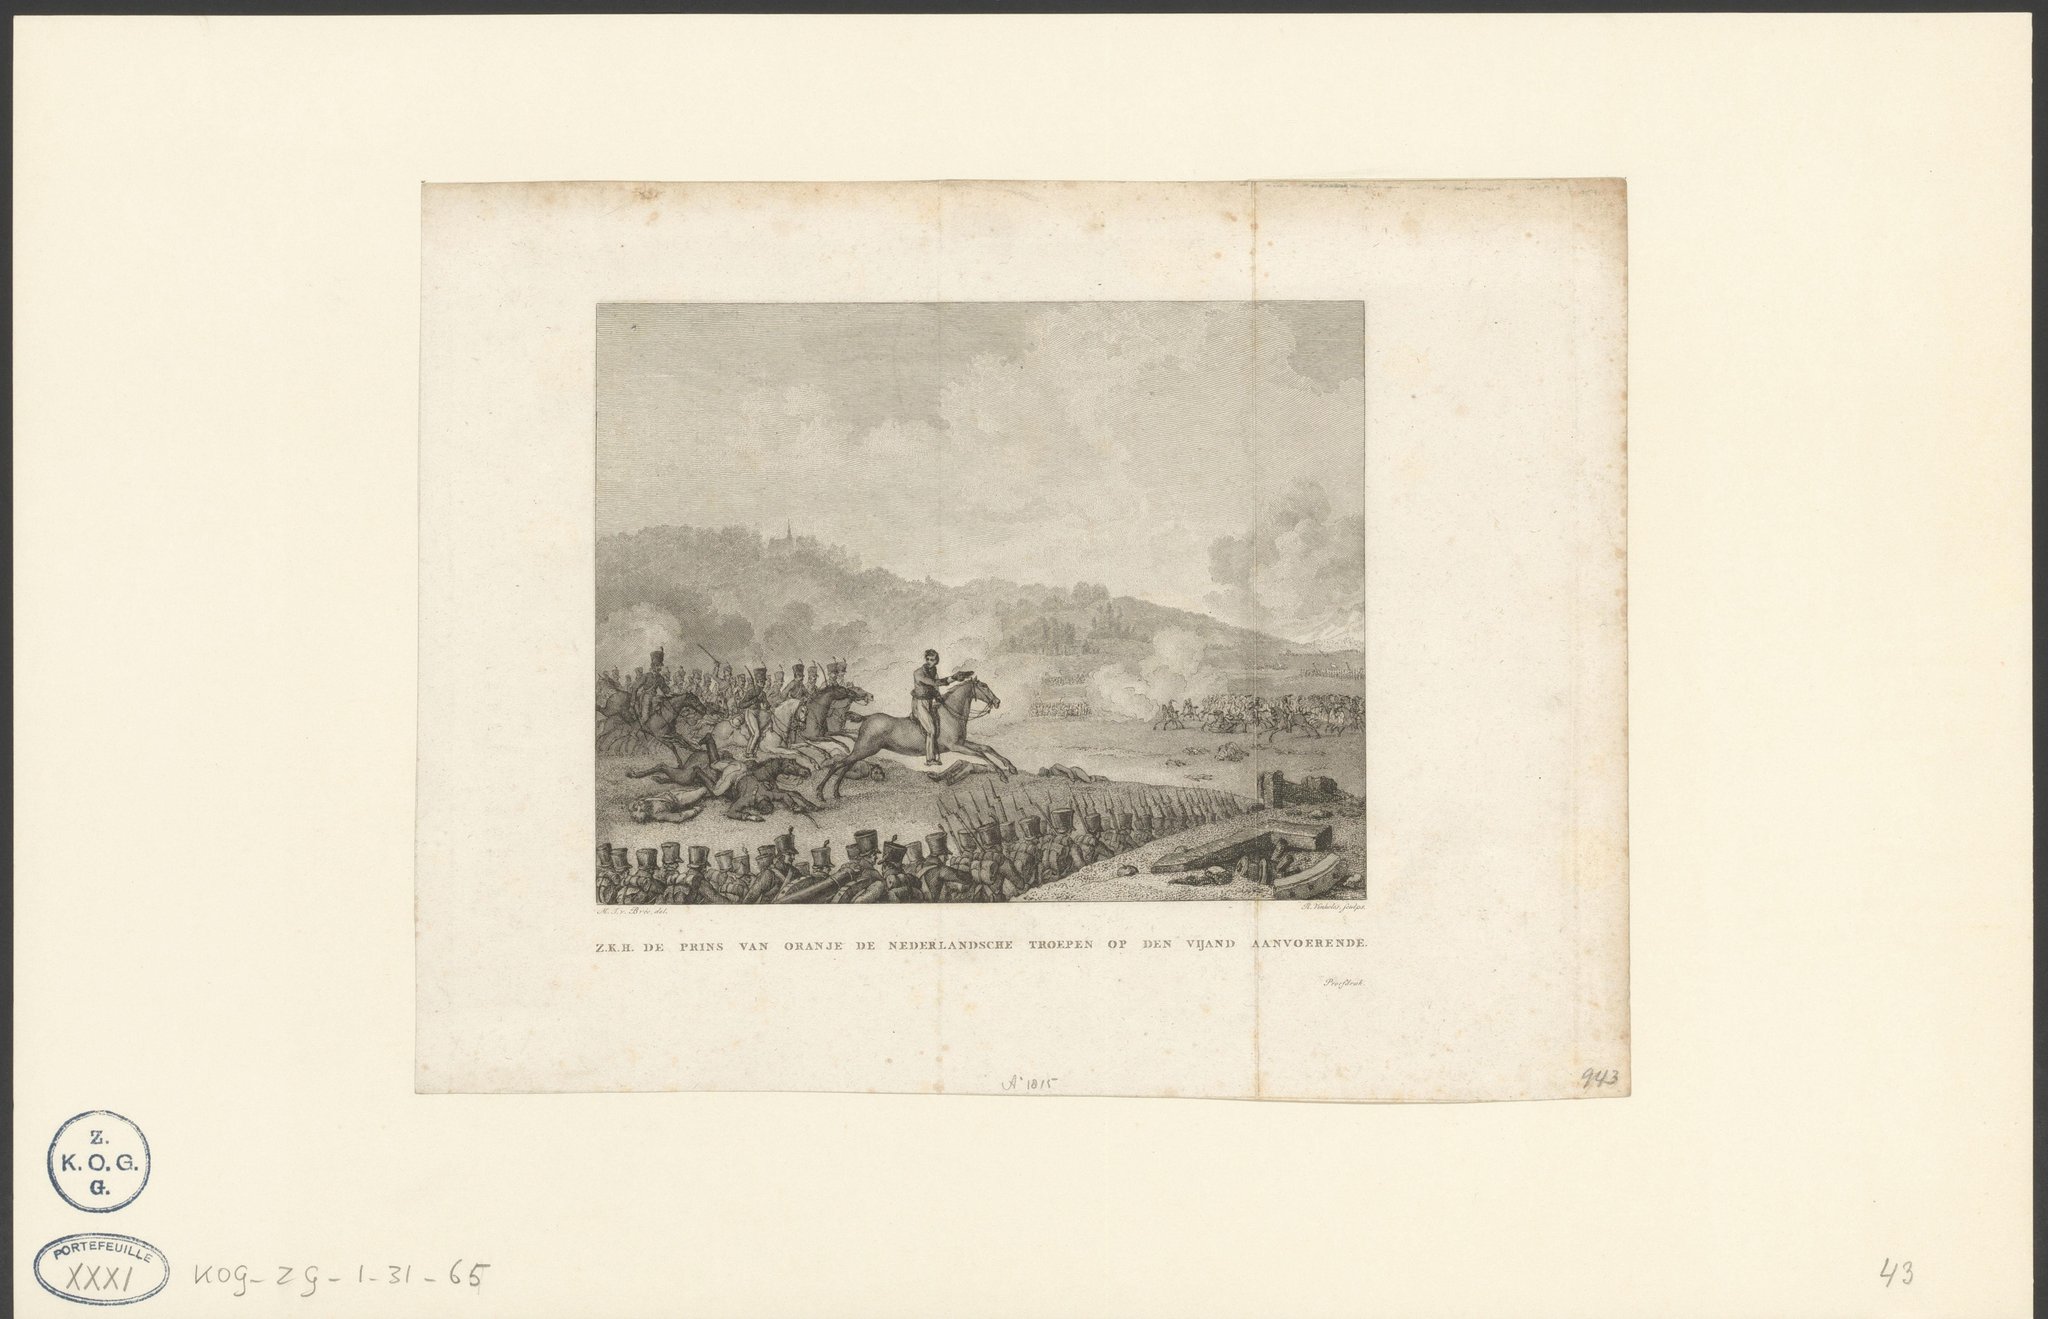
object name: print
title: Z.K.H. De prins van Oranje de Nederlandsche troepen op den vijand aanvoerende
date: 1815-1816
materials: paper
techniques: engraving, etching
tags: the hague, william ii of the netherlands, battle (+ land forces)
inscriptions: stamp, collector's mark: Lugt 1641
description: Willem Frederik George, prins van Oranje, leidt de aanval van de Nederlandse troepen tegen de Fransen in de slag bij Quatre-Bras, 16 juni 1815. Onderdeel van een groep illustraties van gebeurtenissen rond en tijdens de veldslagen bij Quatre-Bras en Waterloo, 16-18 juni 1815. Onderwerpsrubrieken binnen de Atlas Zeden en Gewoonten: Portretten, Portretten van Vorsten uit het huis van Oranje, Regeerende Vorsten, Koningen uit het huis van Oranje.